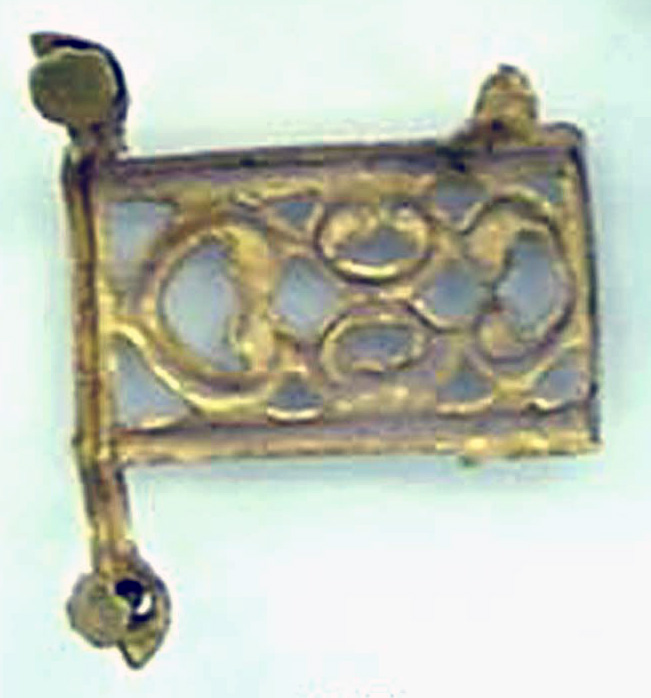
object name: fitting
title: Openwork Fitting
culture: chinese or central asian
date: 601-900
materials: gold